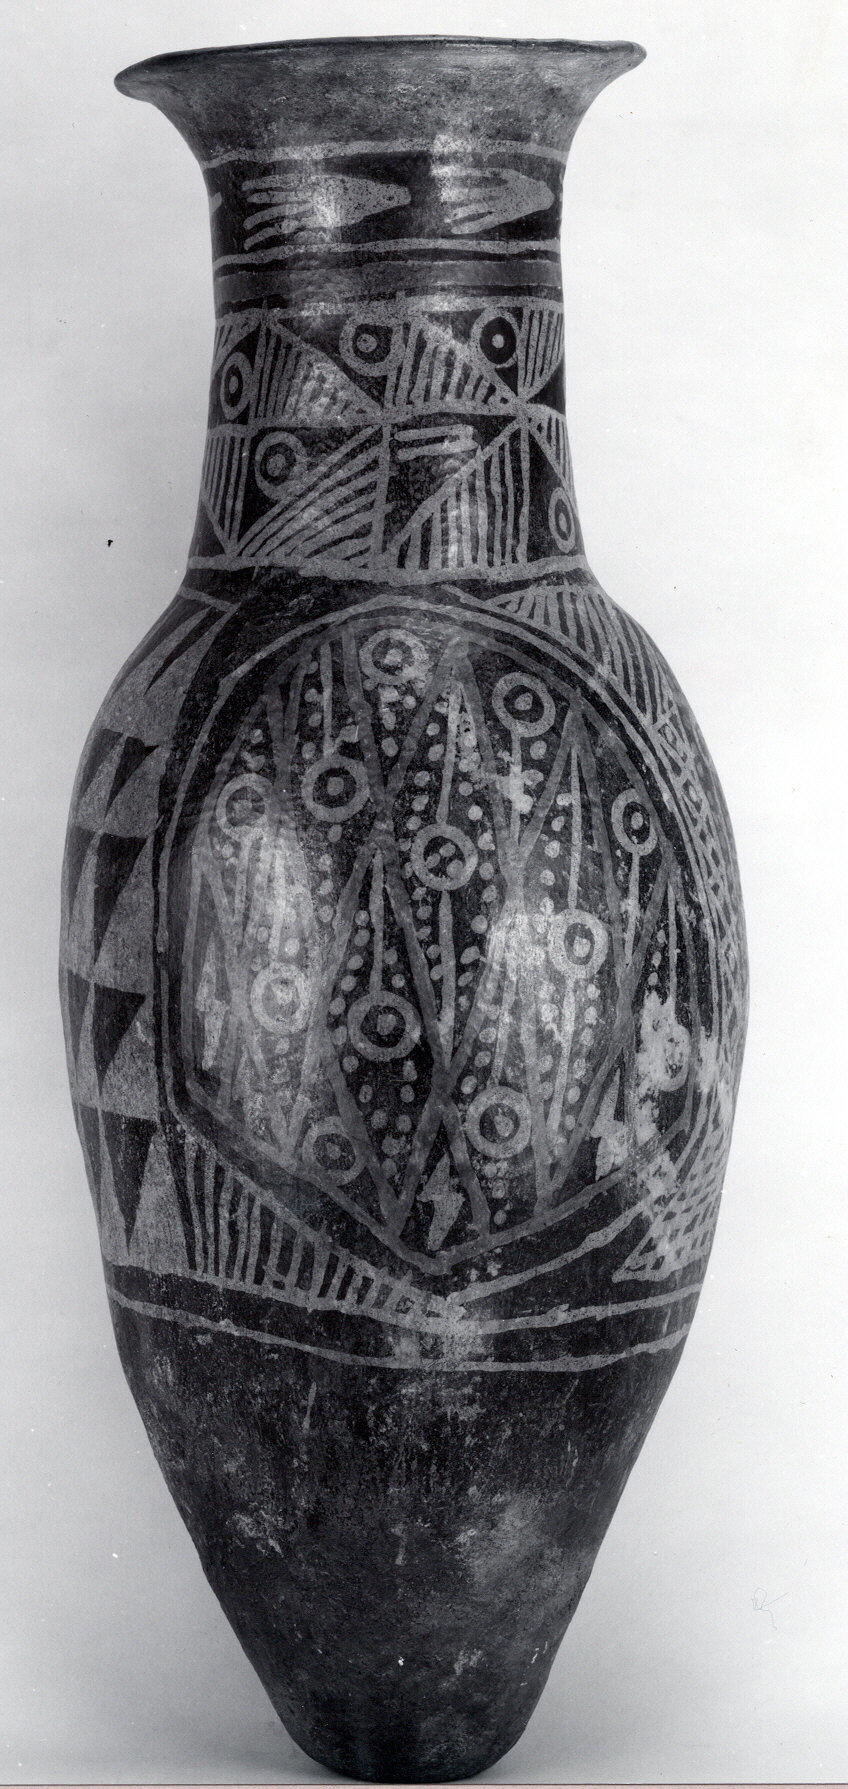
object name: urn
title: Ceramic Urn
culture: carchi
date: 1001-1600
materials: ceramic, pigment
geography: ecuador